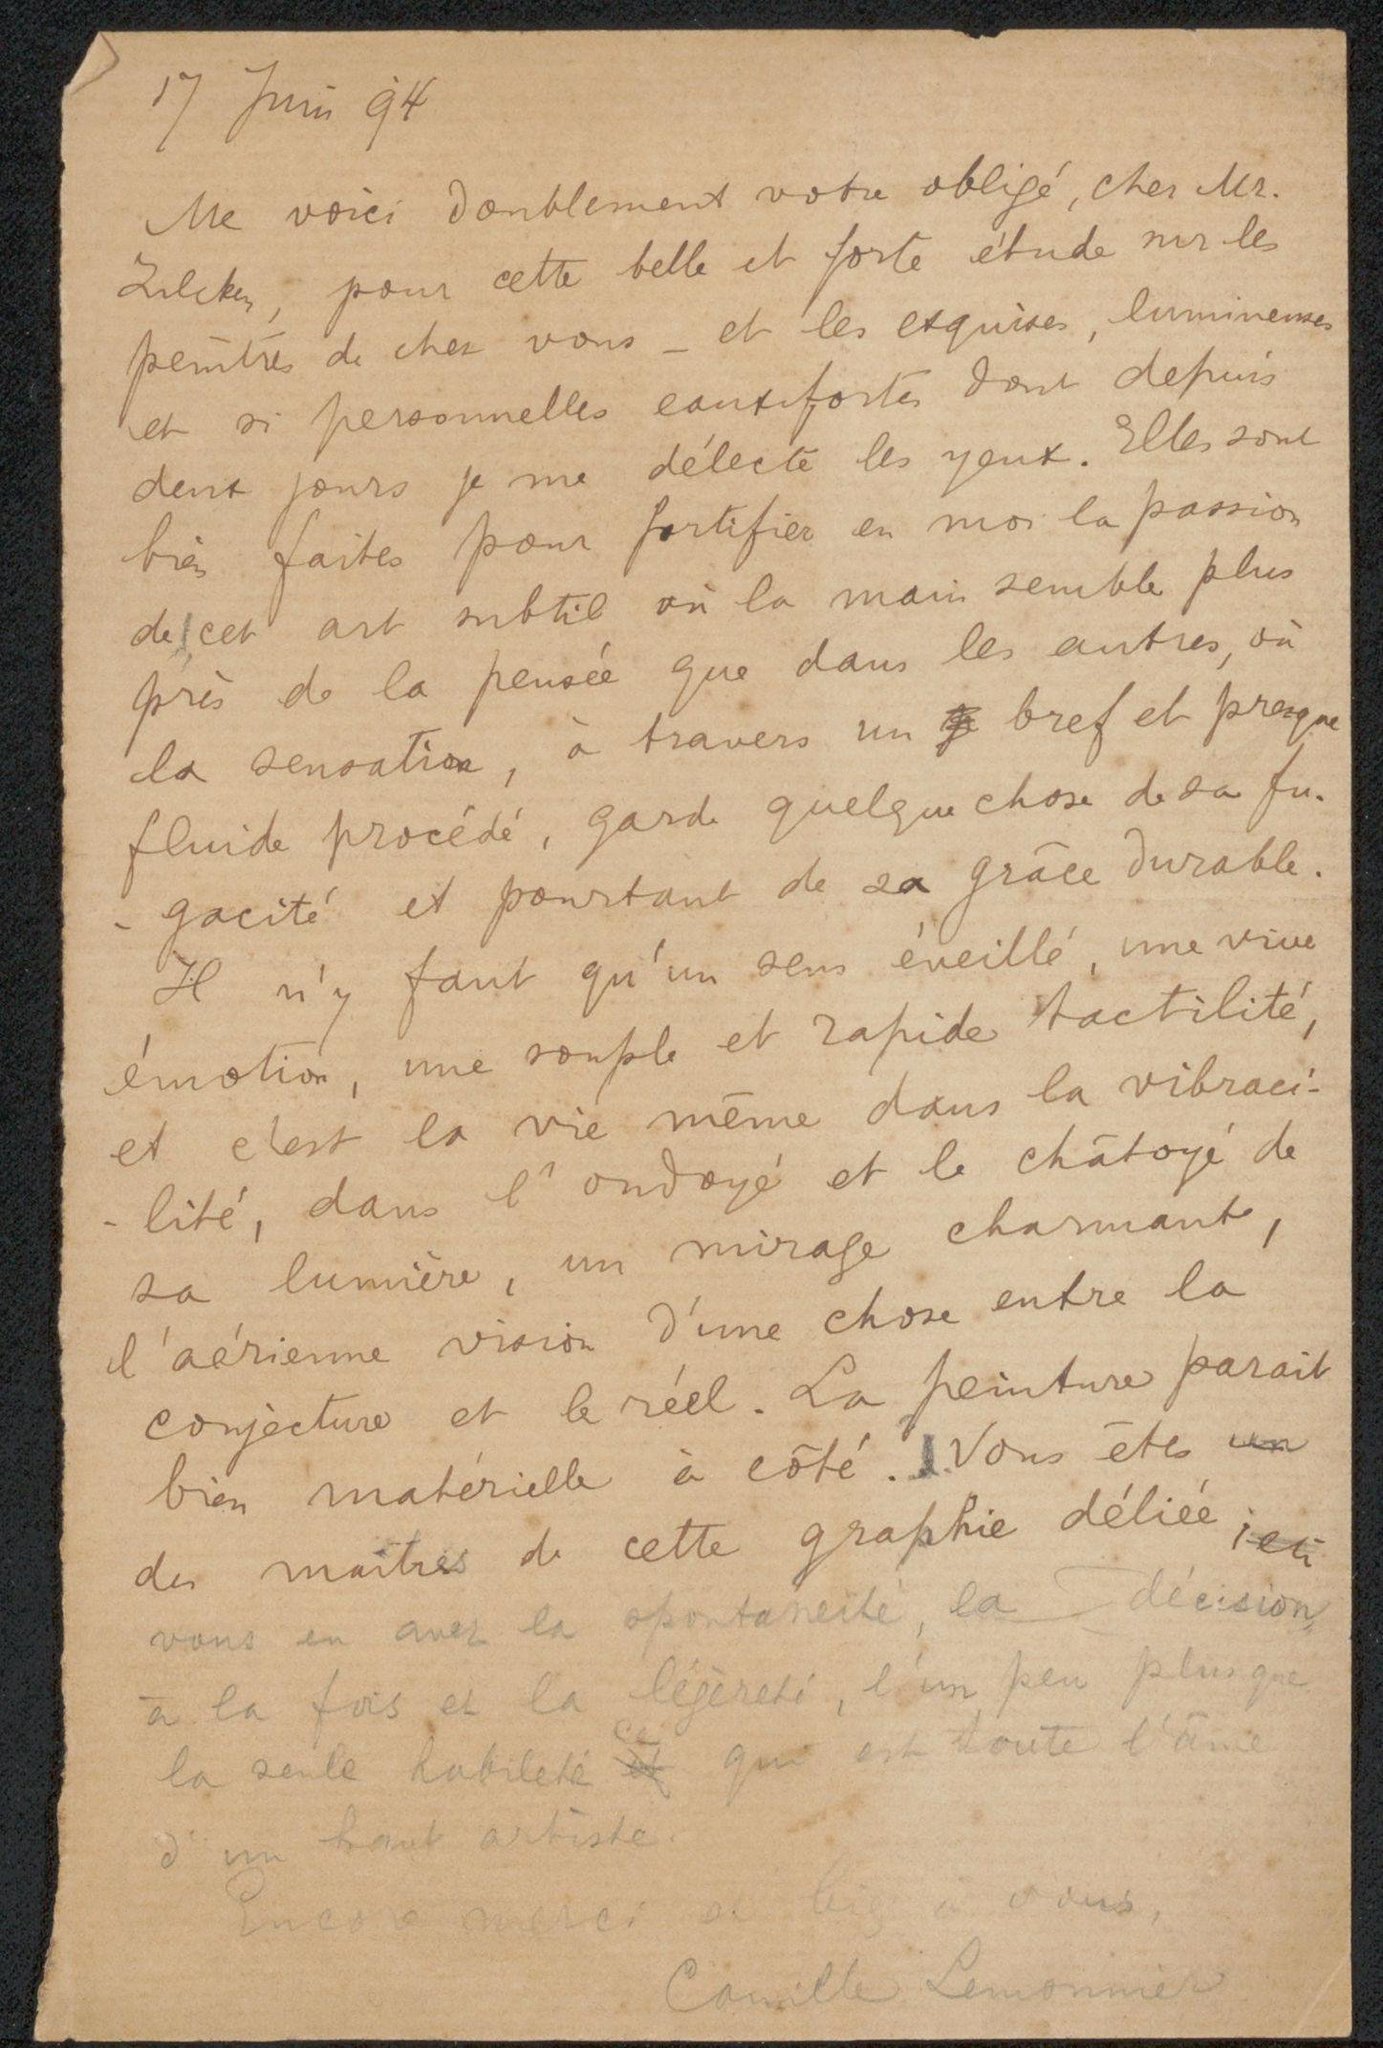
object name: letter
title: Transcriptie van een brief aan Philip Zilcken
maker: philip zilcken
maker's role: draughtsman, painter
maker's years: 1857-1930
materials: ink, paper, pencil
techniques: pen, writing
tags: the graphic arts, painting (including book-illumination, miniature-painting)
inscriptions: collector's mark: ‘RPK’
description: Betreft een transcriptie van brief RP-D-1982-43-LEMONNIER(C.)-4A.